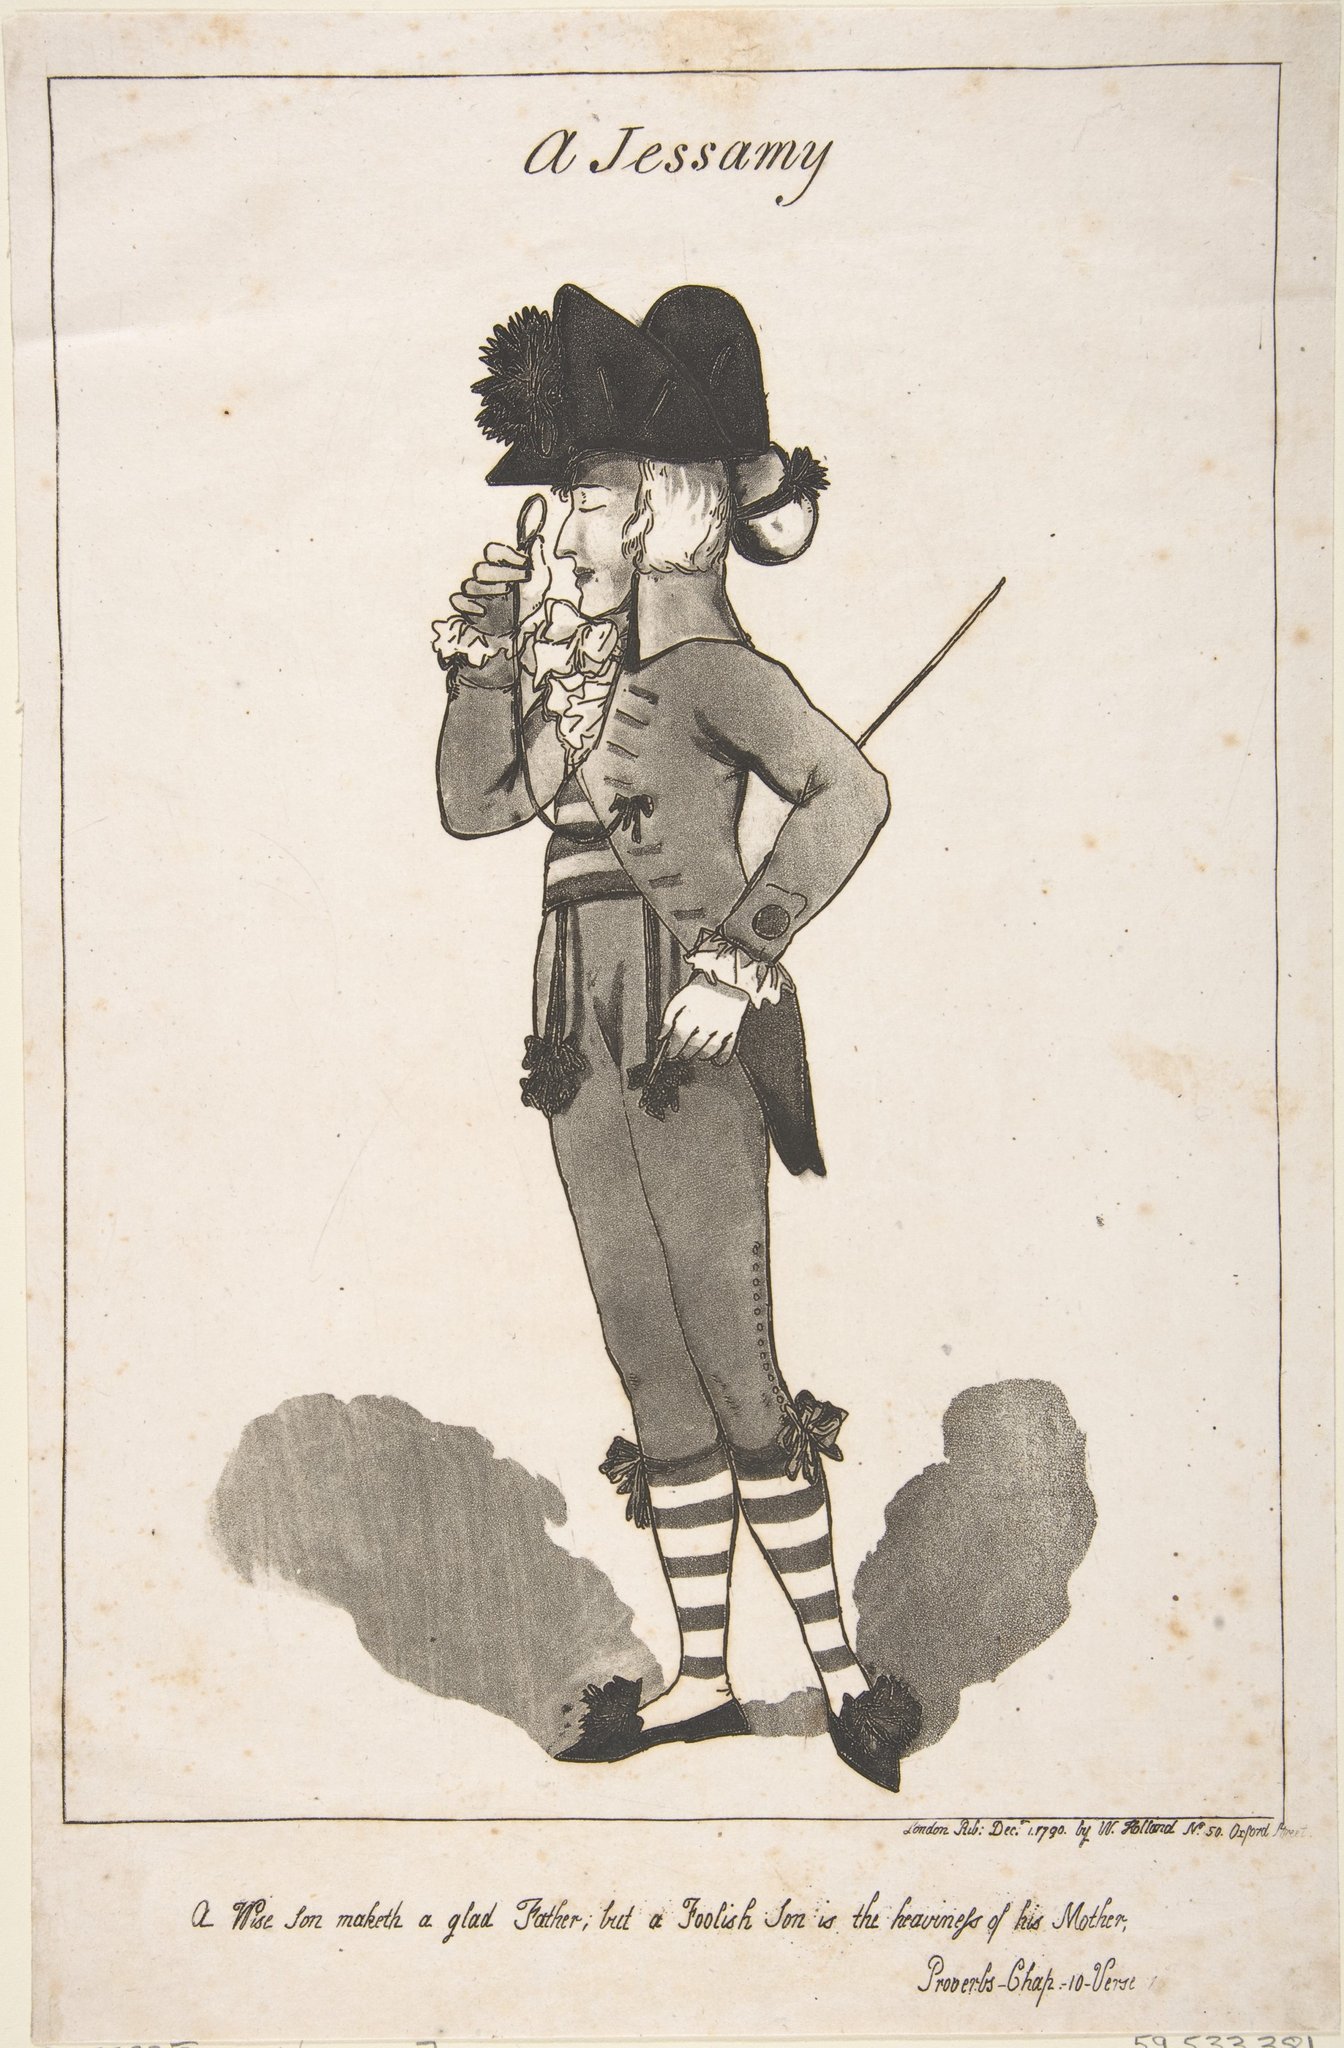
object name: print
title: A Jessamy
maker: thomas rowlandson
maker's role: artist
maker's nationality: british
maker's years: 1757-1827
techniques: aquatint, etching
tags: satire,men